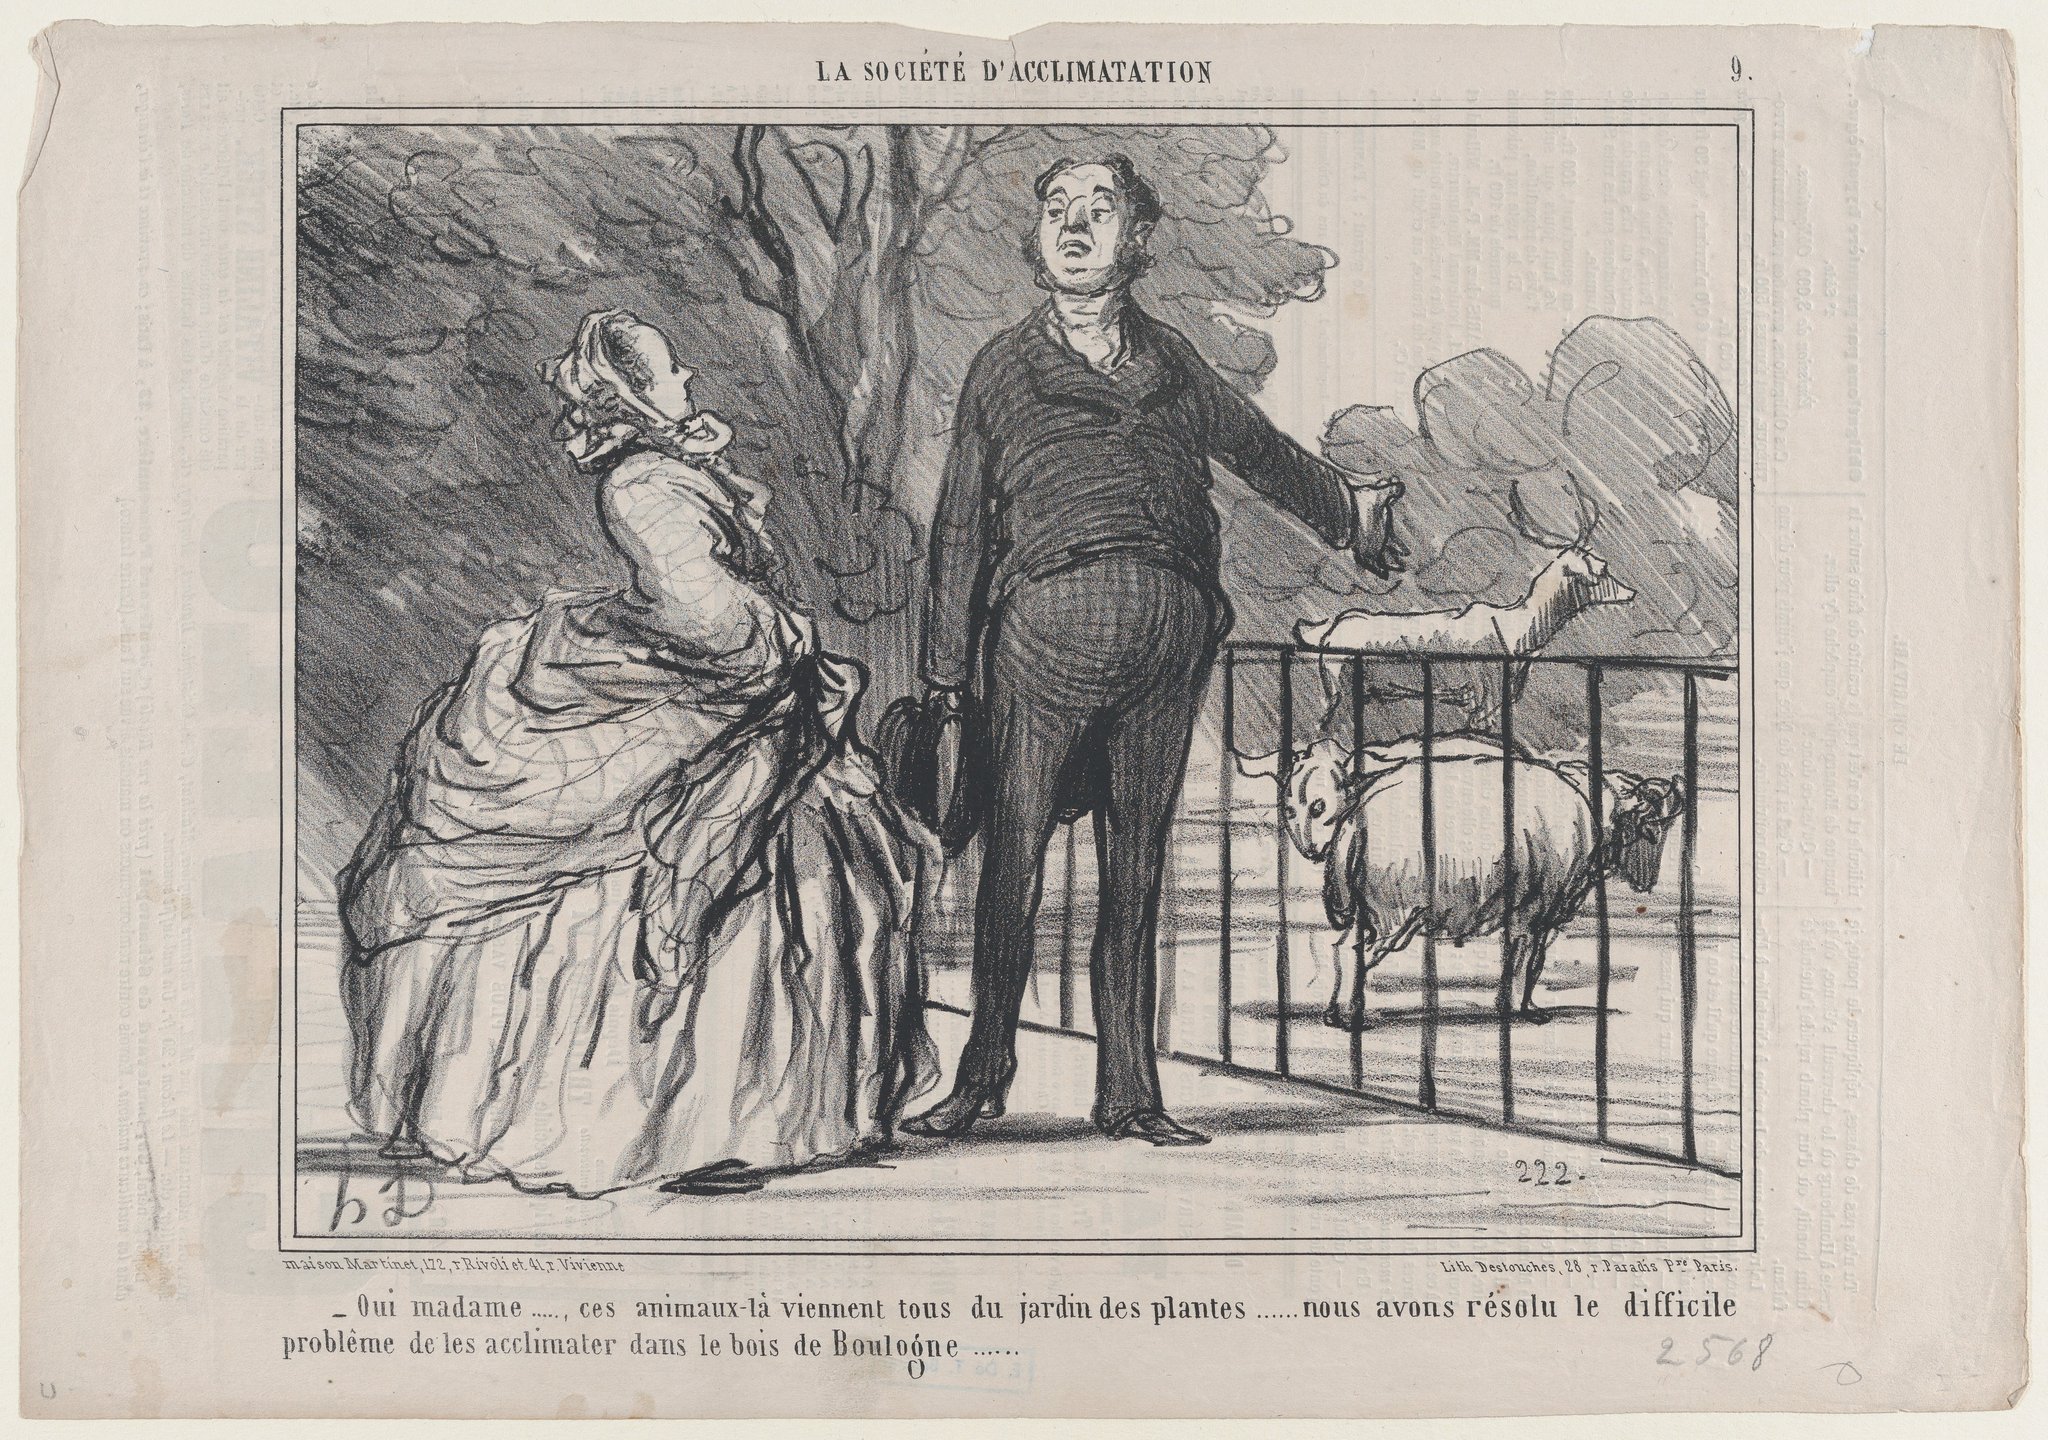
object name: print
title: Oui madame..., ces animaux-là viennent tous du jardin des plantes..., from La Société d'Acclimatation, published in "Le Charivari"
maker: honoré daumier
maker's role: artist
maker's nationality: french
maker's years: 1808-1879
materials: paper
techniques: lithograph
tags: animals,men,women